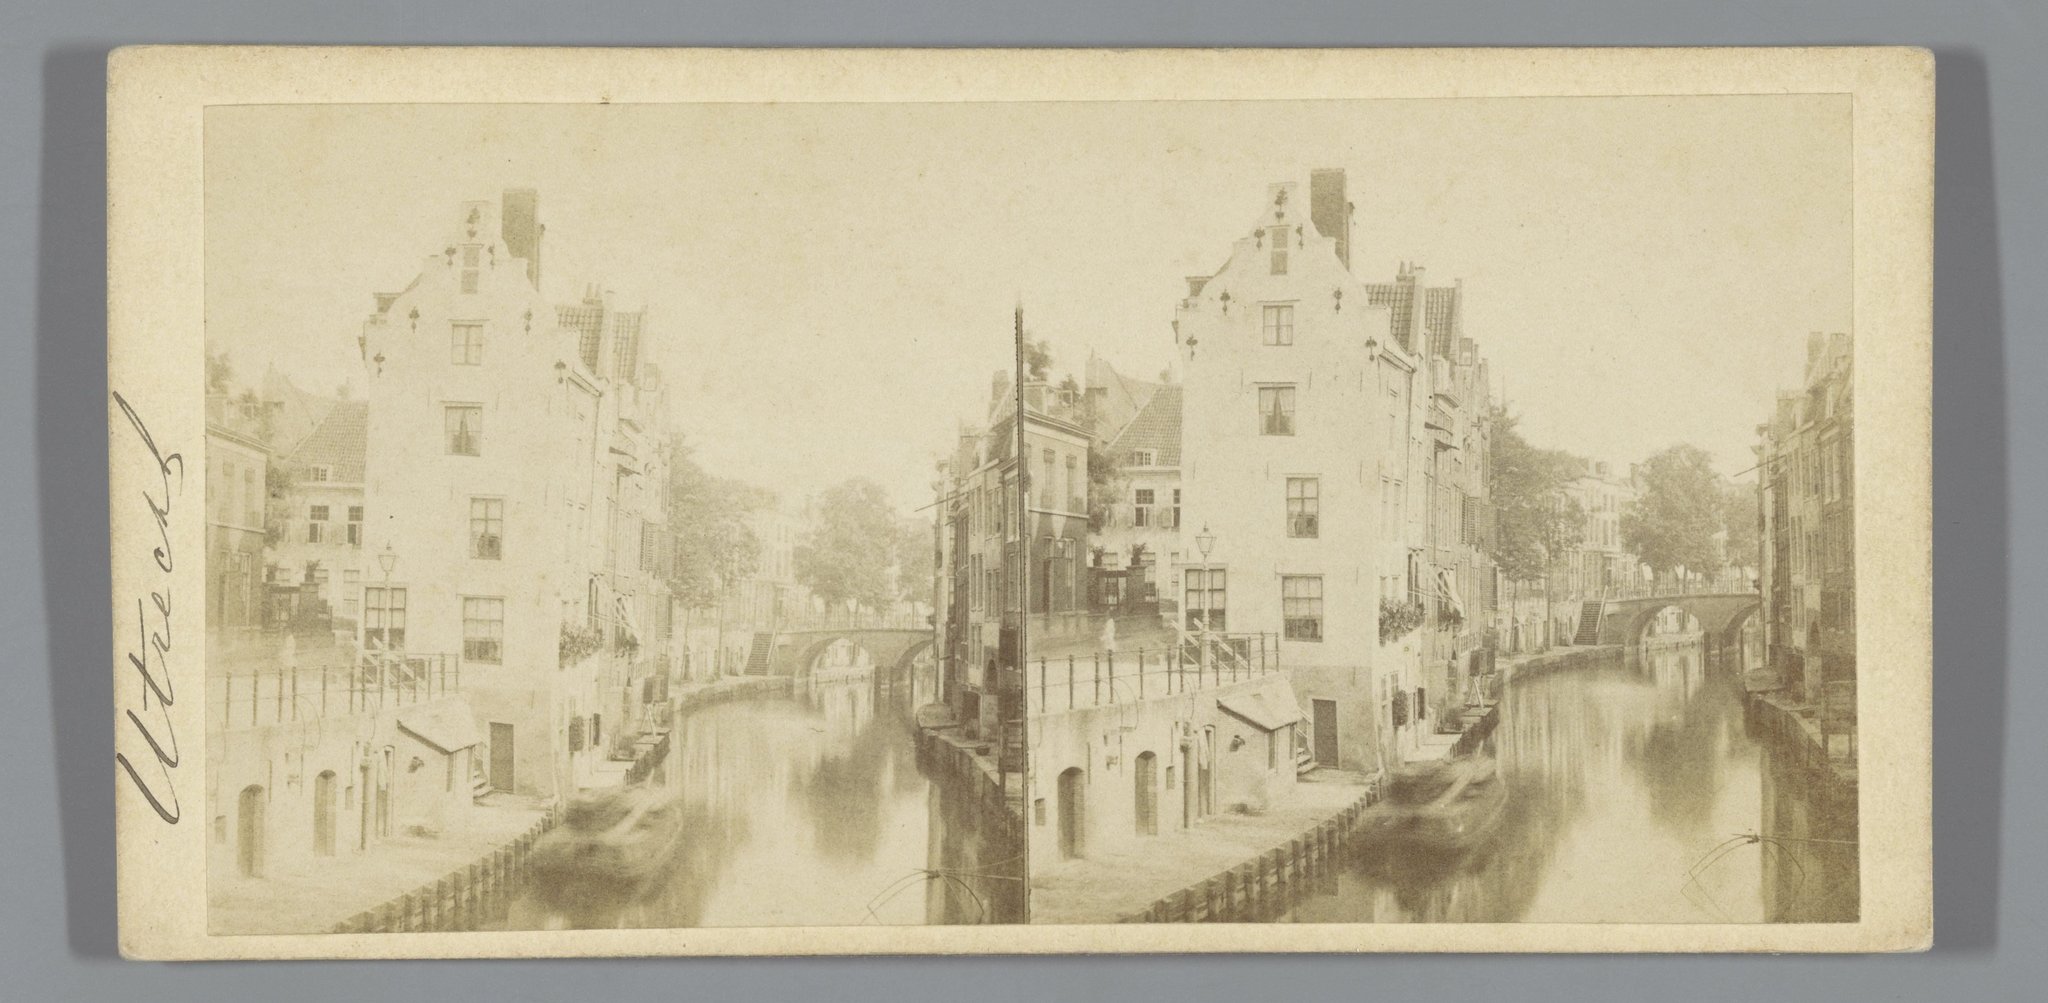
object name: stereograph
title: Huizen aan de Donkere Gaard en de Oudegracht, Utrecht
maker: pieter oosterhuis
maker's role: draughtsman, print maker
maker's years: 1816-1885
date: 1859-1865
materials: cardboard, paper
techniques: albumen print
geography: utrecht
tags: canals, waters (in city)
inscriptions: number: ‘58’, inscription: ‘Donkere Gaard’, inscription: ‘Utrecht’, inscription: ‘P.’, number: ‘No. 1’